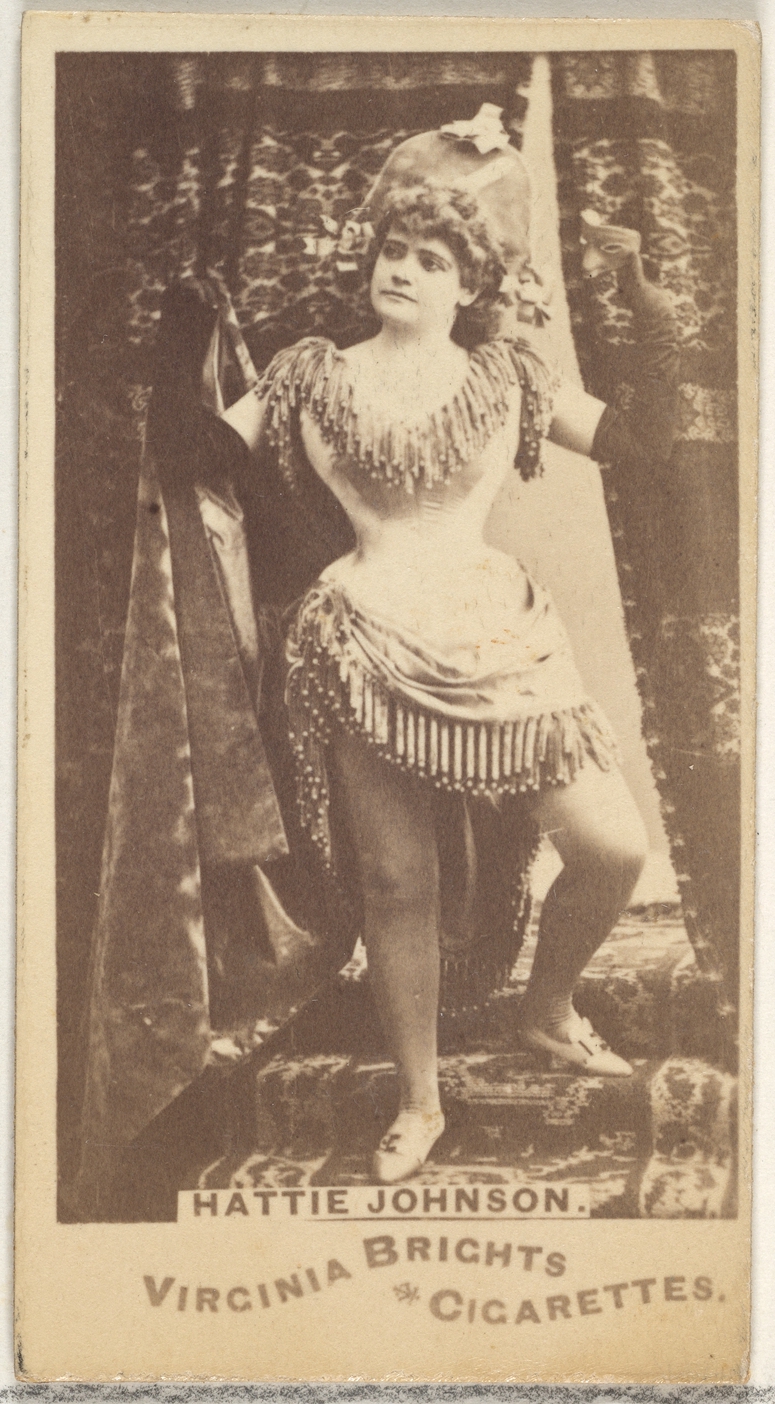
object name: photograph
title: Hattie Johnson, from the Actors and Actresses series (N45, Type 1) for Virginia Brights Cigarettes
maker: allen & ginter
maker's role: publisher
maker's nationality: american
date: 1888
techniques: albumen silver print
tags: portraits,women,actresses